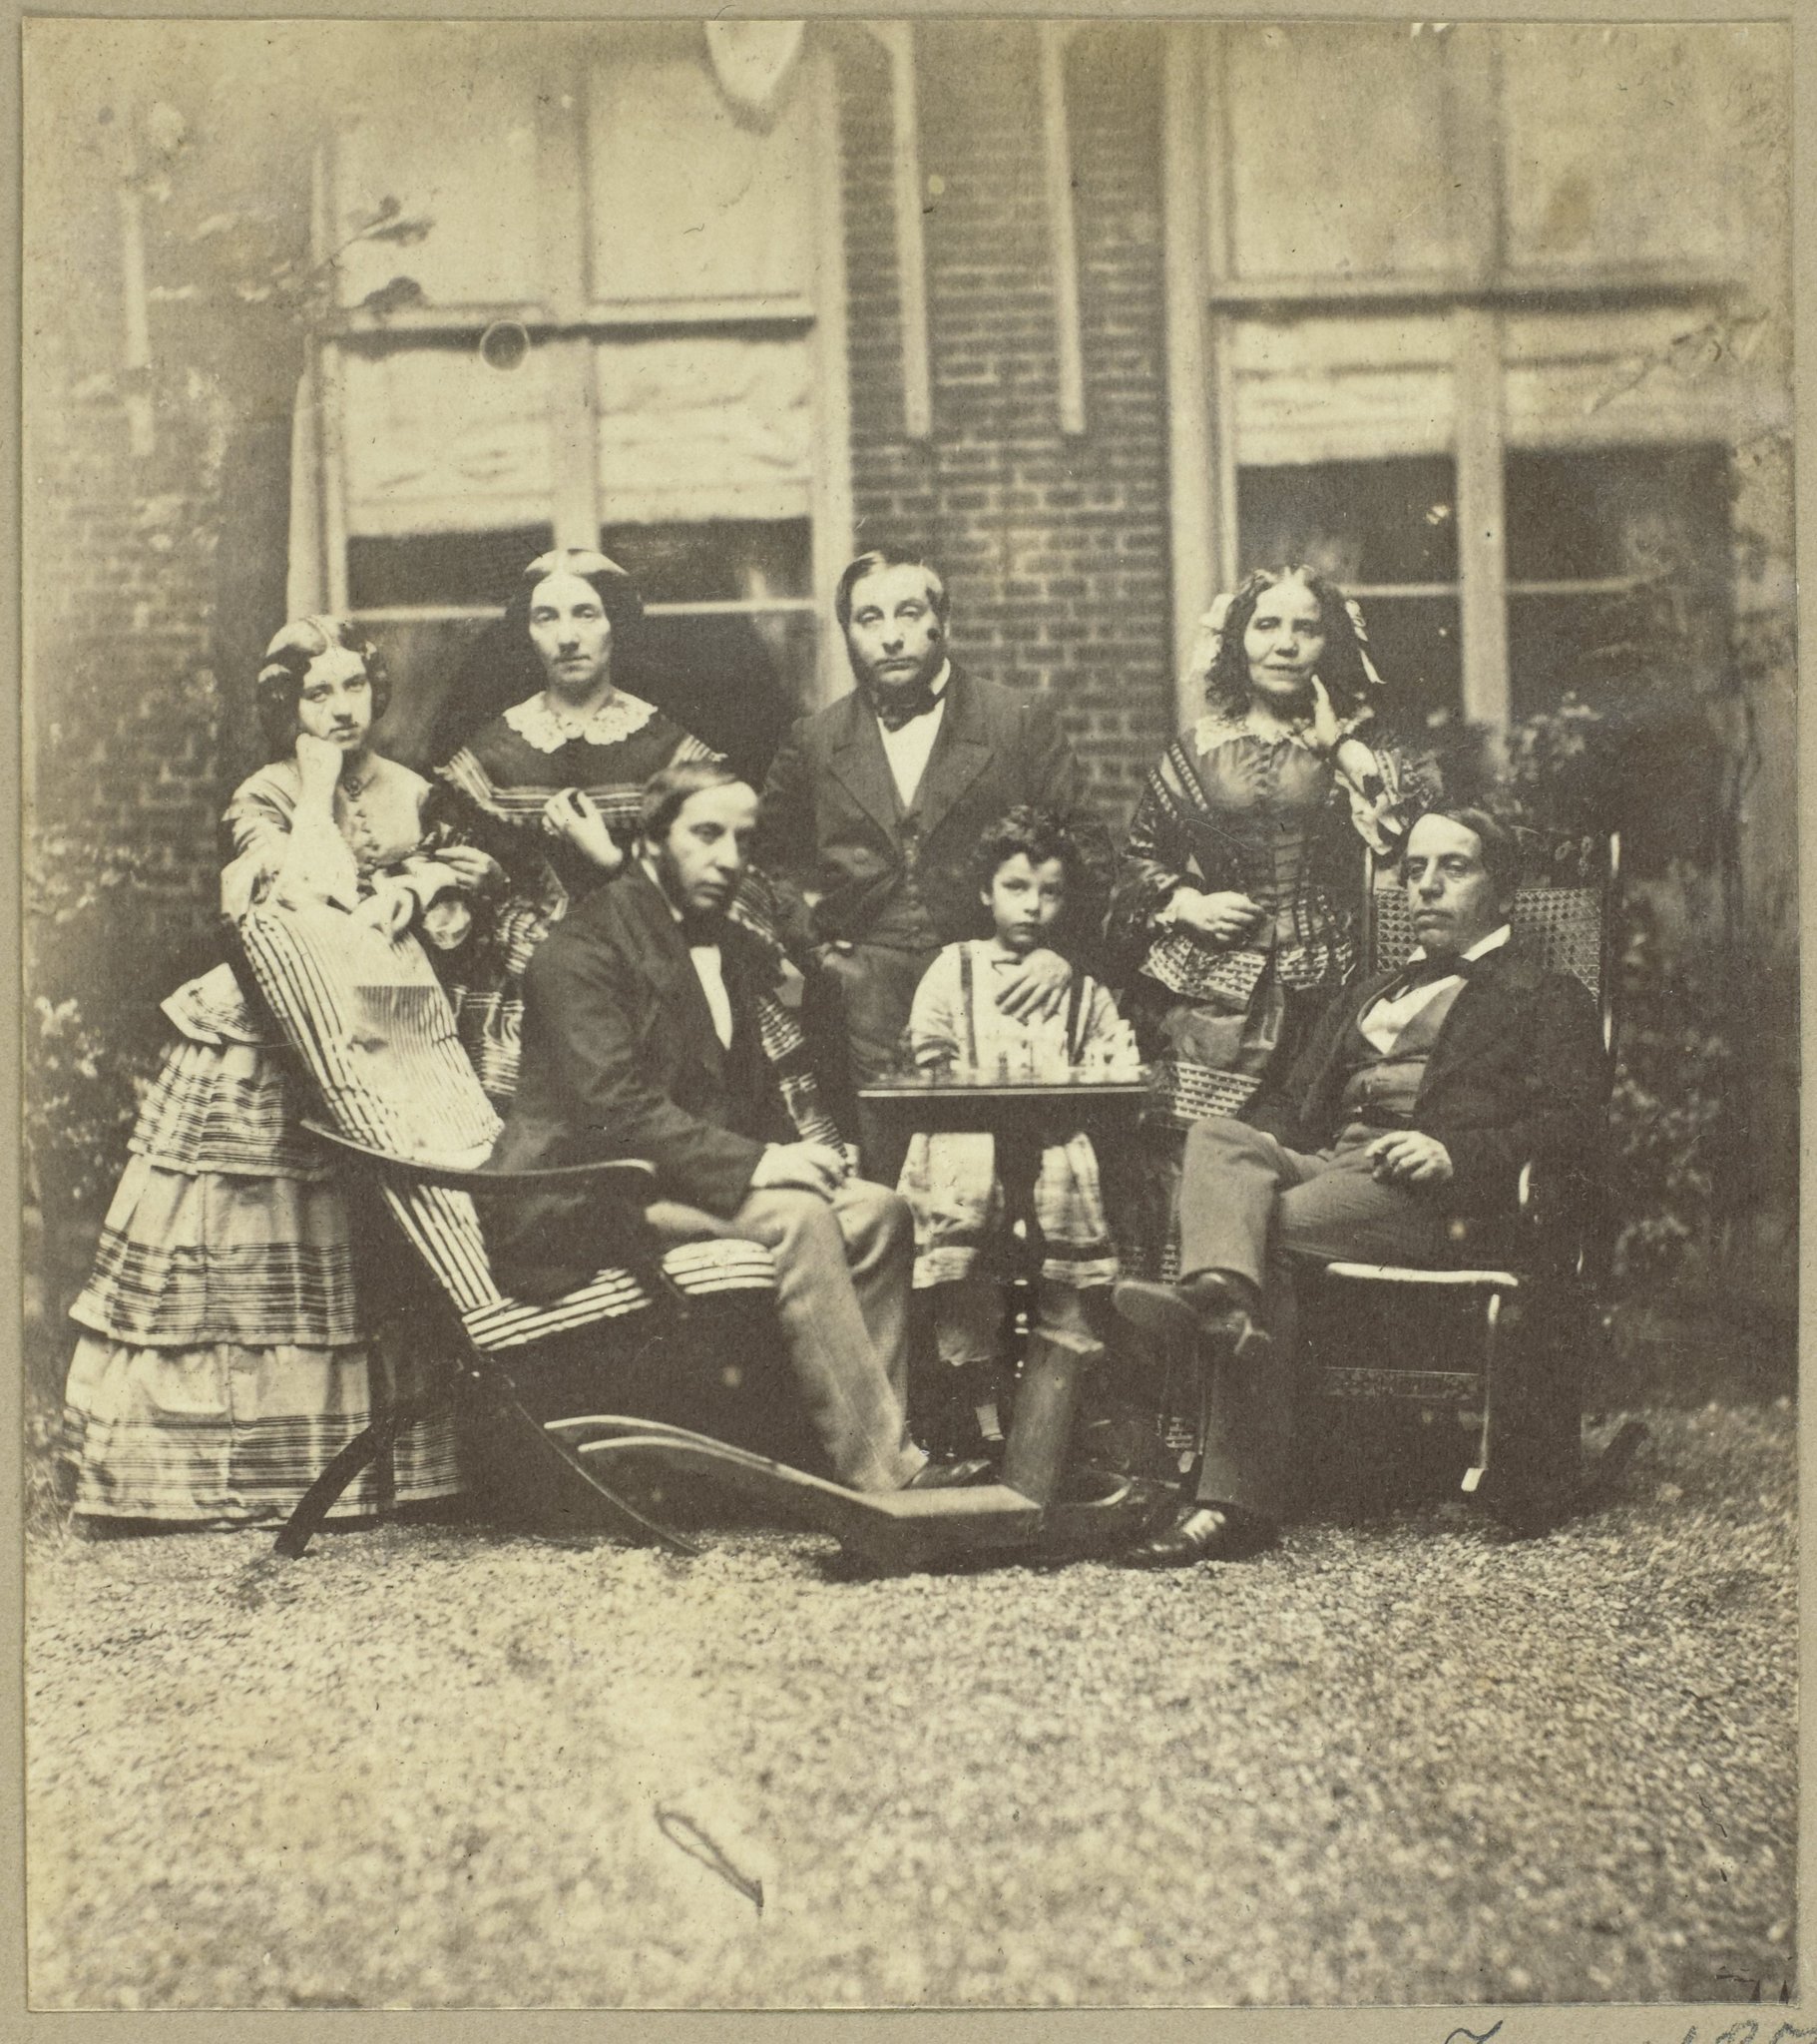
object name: photograph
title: Groepsportret van leden van de families Asser en Oppenheim in een tuin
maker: eduard isaac asser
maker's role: amateurfotograaf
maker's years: 1809-1894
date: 1806-1856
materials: cardboard, paper, photographic support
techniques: salted paper print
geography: amsterdam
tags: portrait, self-portrait of photographer (+ the artist and his family, relatives, etc.)